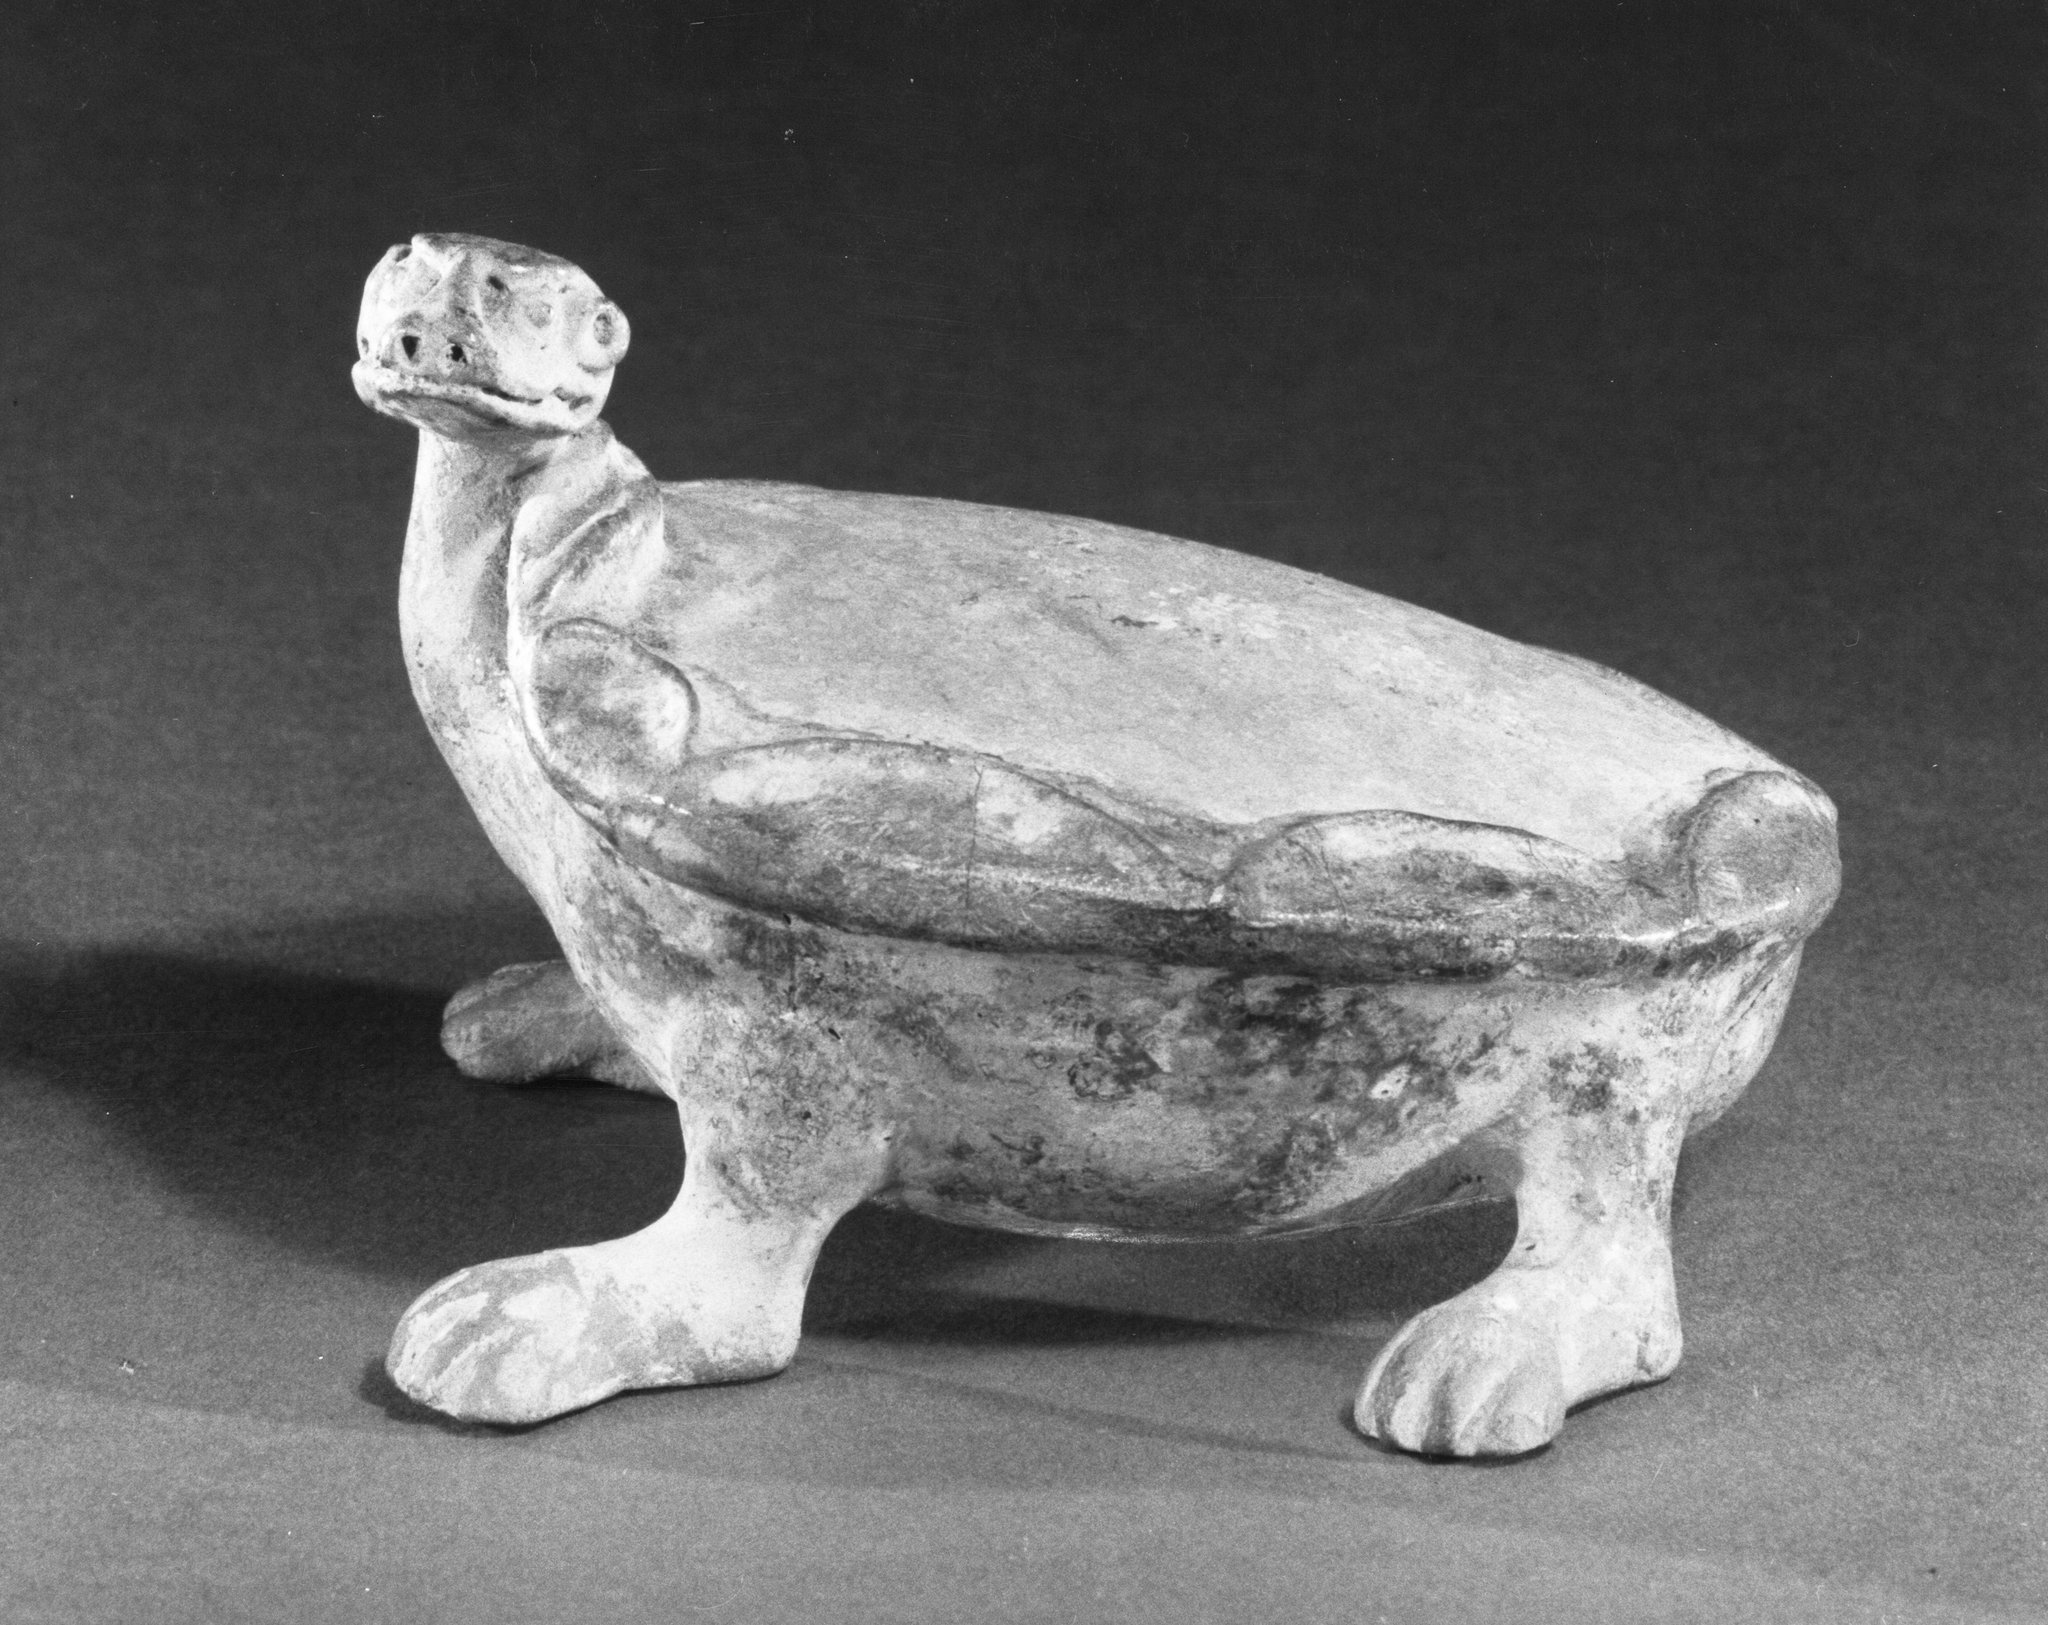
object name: figure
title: Tortoise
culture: chinese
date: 206 BCE-220 CE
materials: earthenware, glaze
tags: turtles